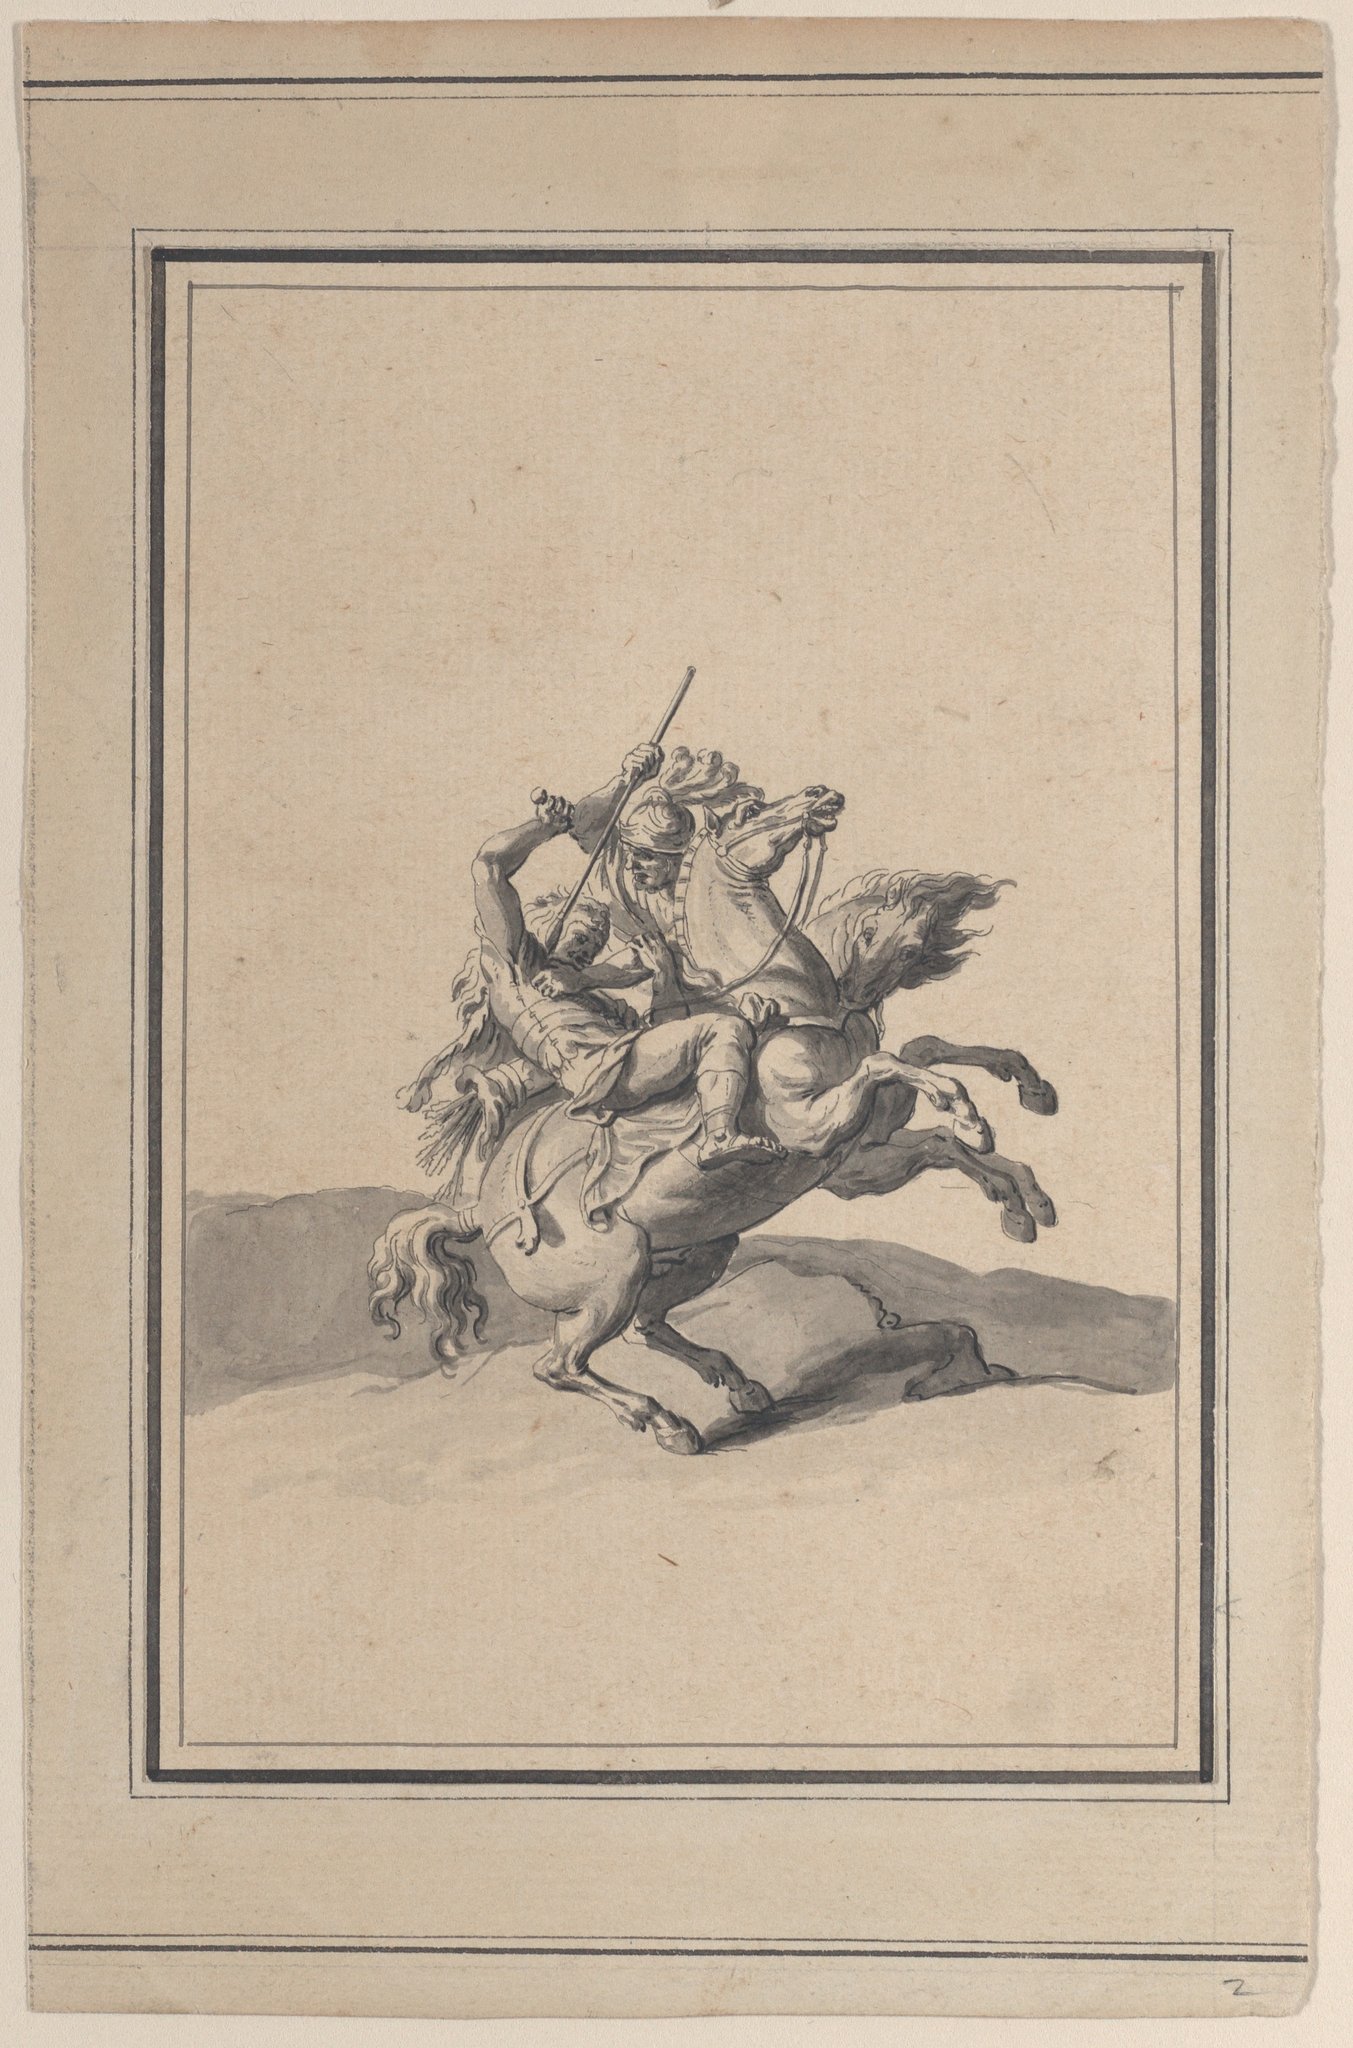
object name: drawing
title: Vignette, from "The Battle of Milvian"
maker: bernard picart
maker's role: artist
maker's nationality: french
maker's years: 1673-1733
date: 1701-1733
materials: ink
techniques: brush, pen, wash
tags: men,horses